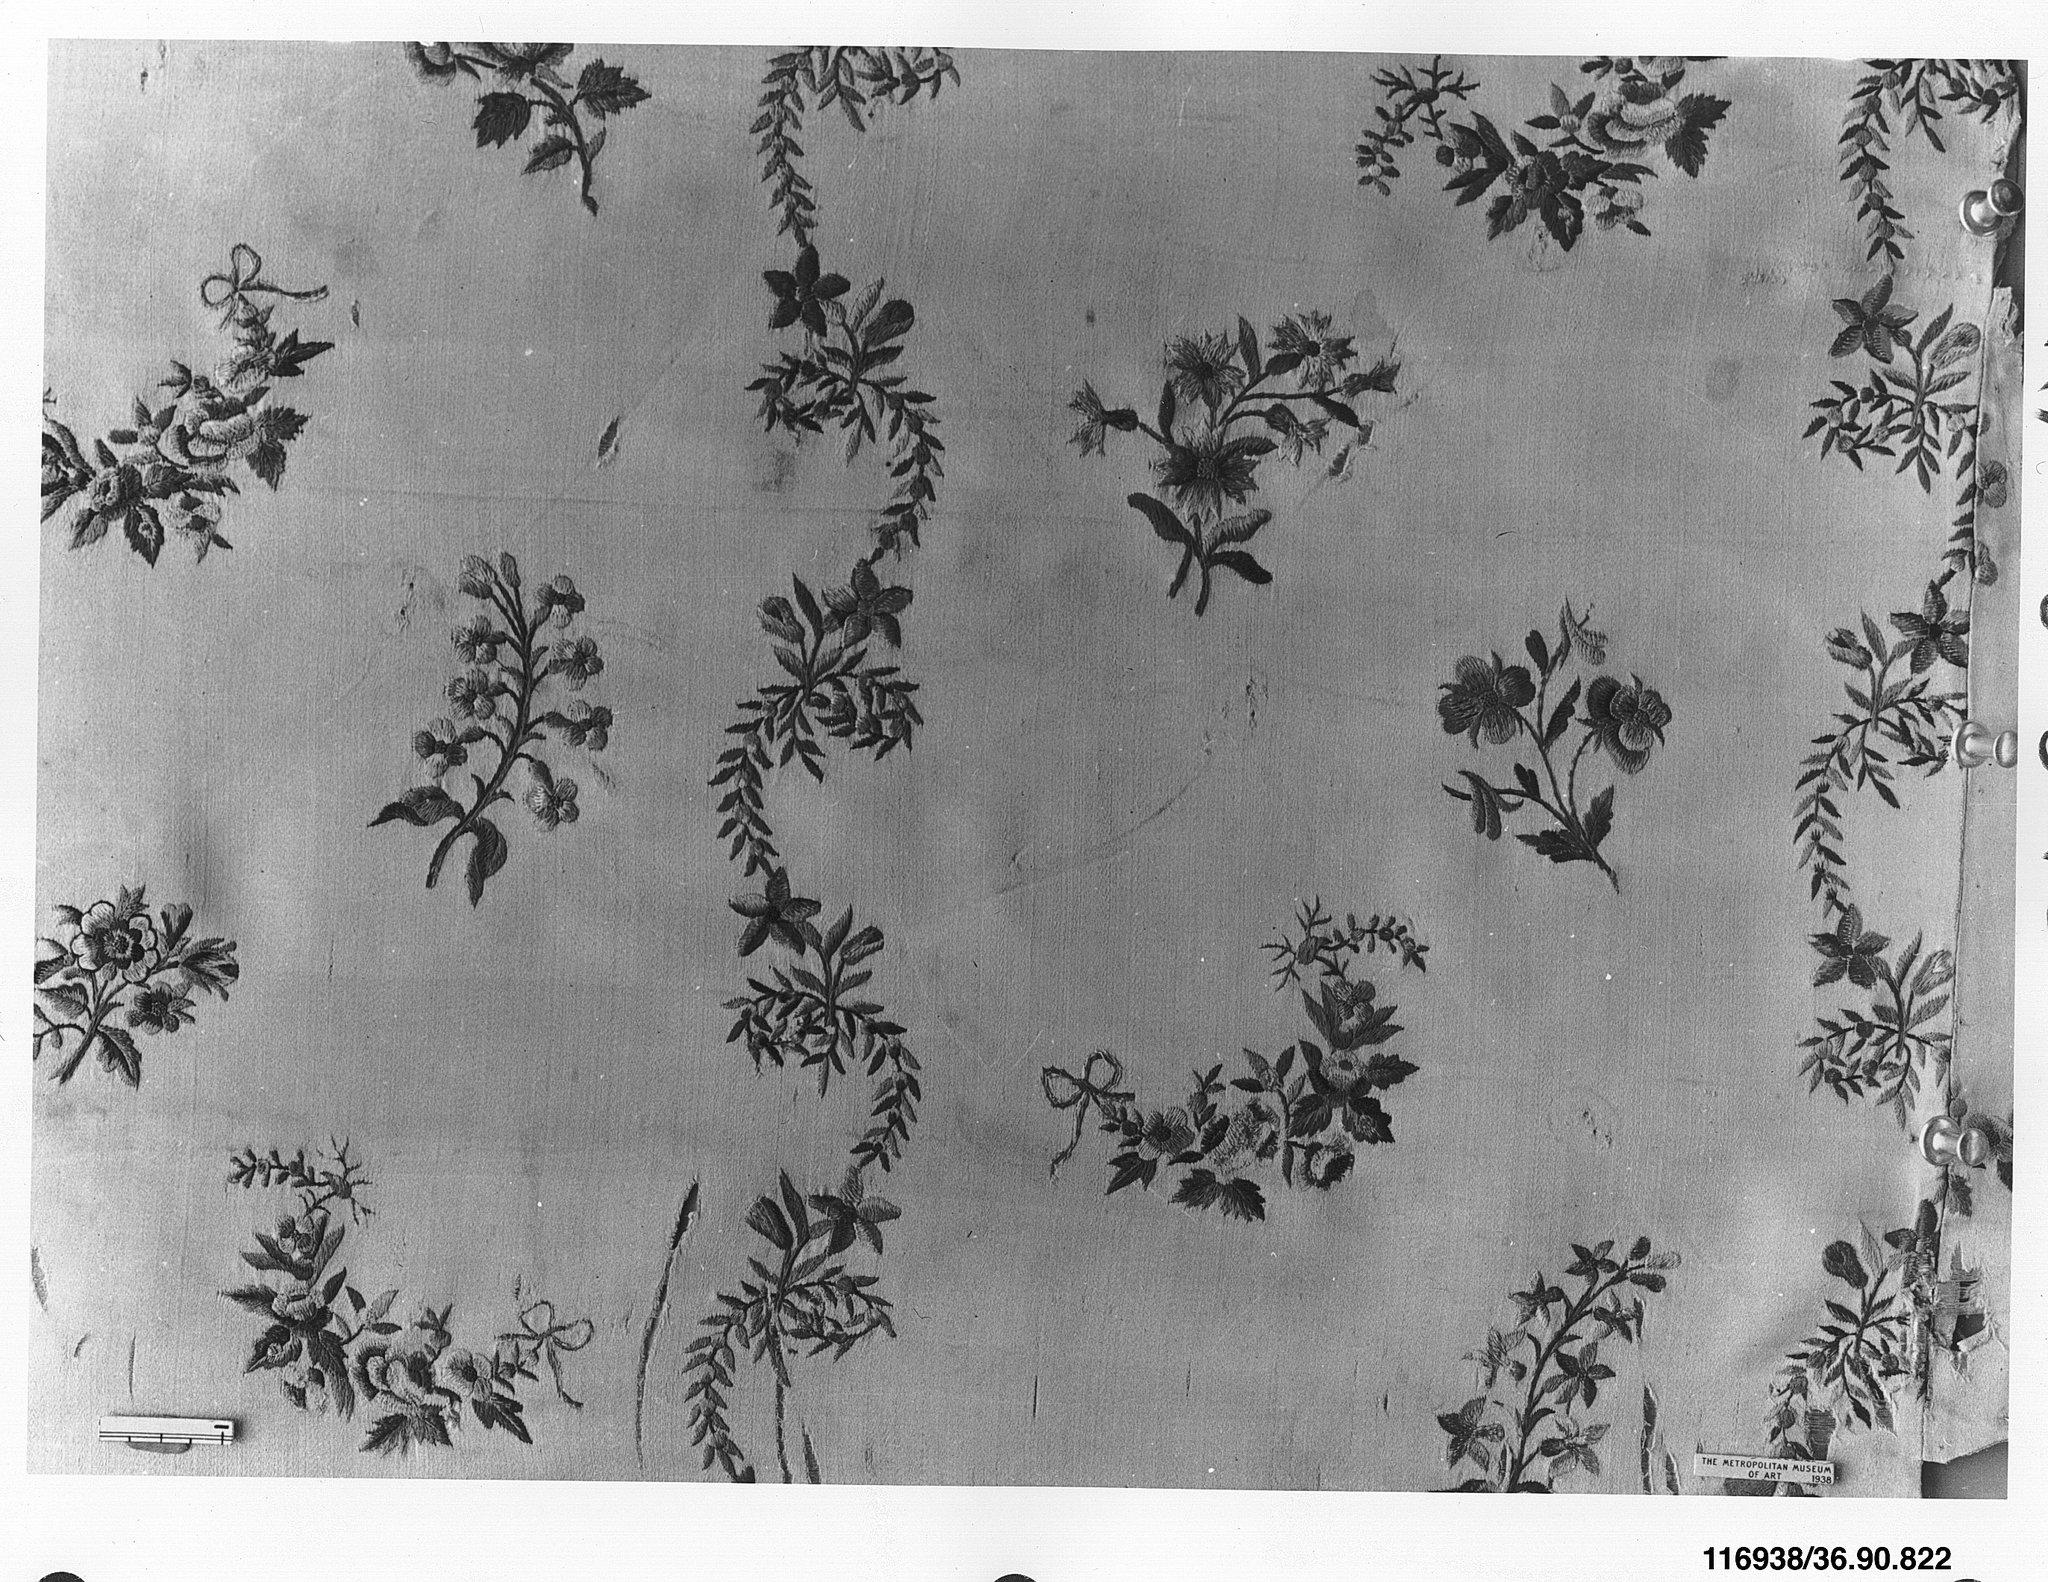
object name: piece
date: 1701-1800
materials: silk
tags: flowers,leaves